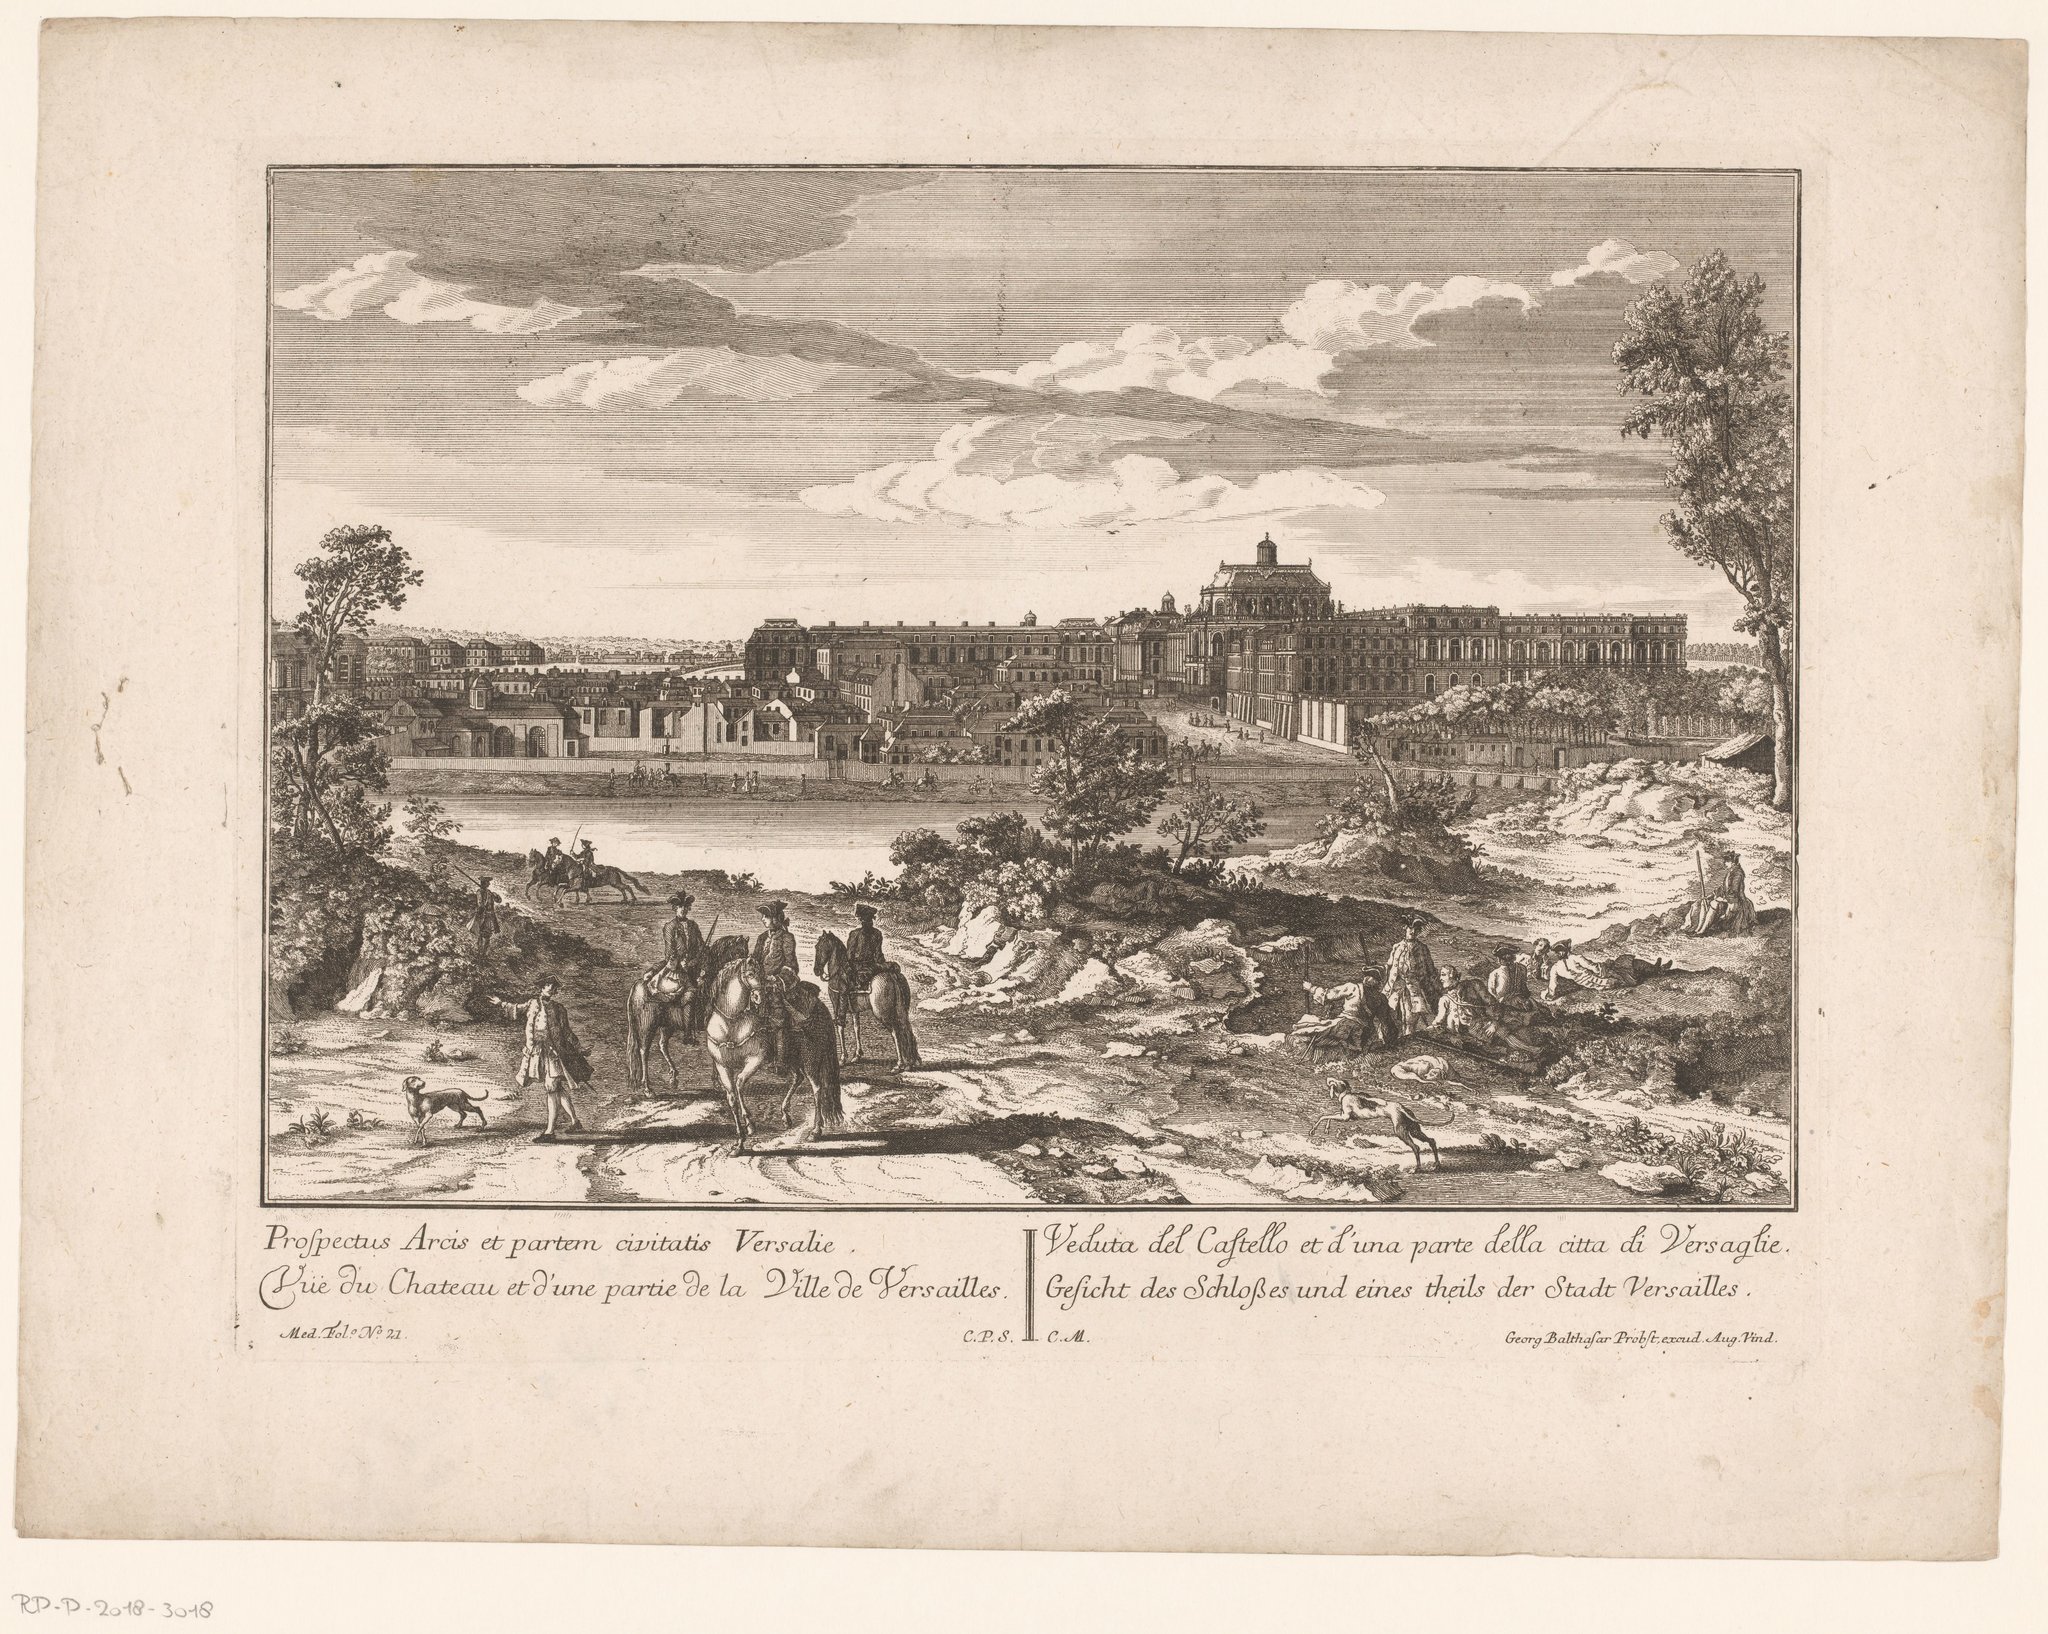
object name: opticaprent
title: Gezicht op het Paleis van Versailles en een deel van de stad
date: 1742-1801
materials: paper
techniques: engraving, etching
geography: augsburg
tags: palace, landscape with tower or castle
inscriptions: collector's mark: Lugt 2228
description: Links onderin het opschrift Med. Fol[i]o No. 21.